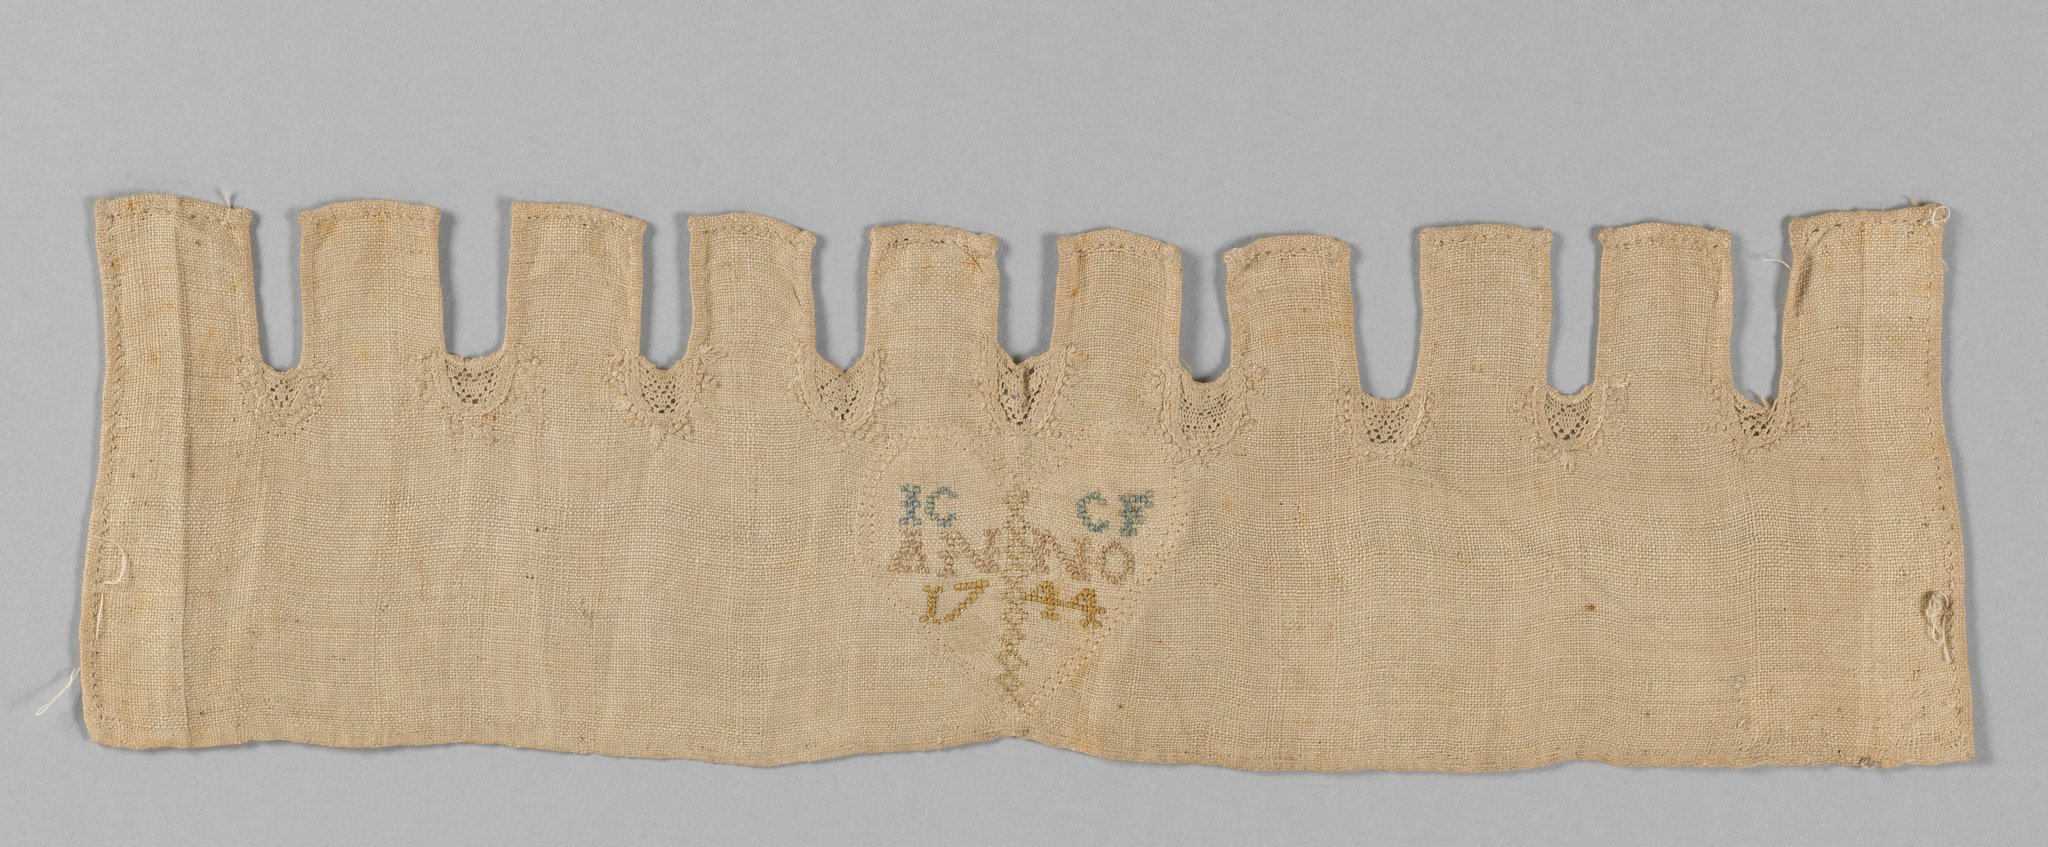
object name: sampler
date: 1744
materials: linen, silk